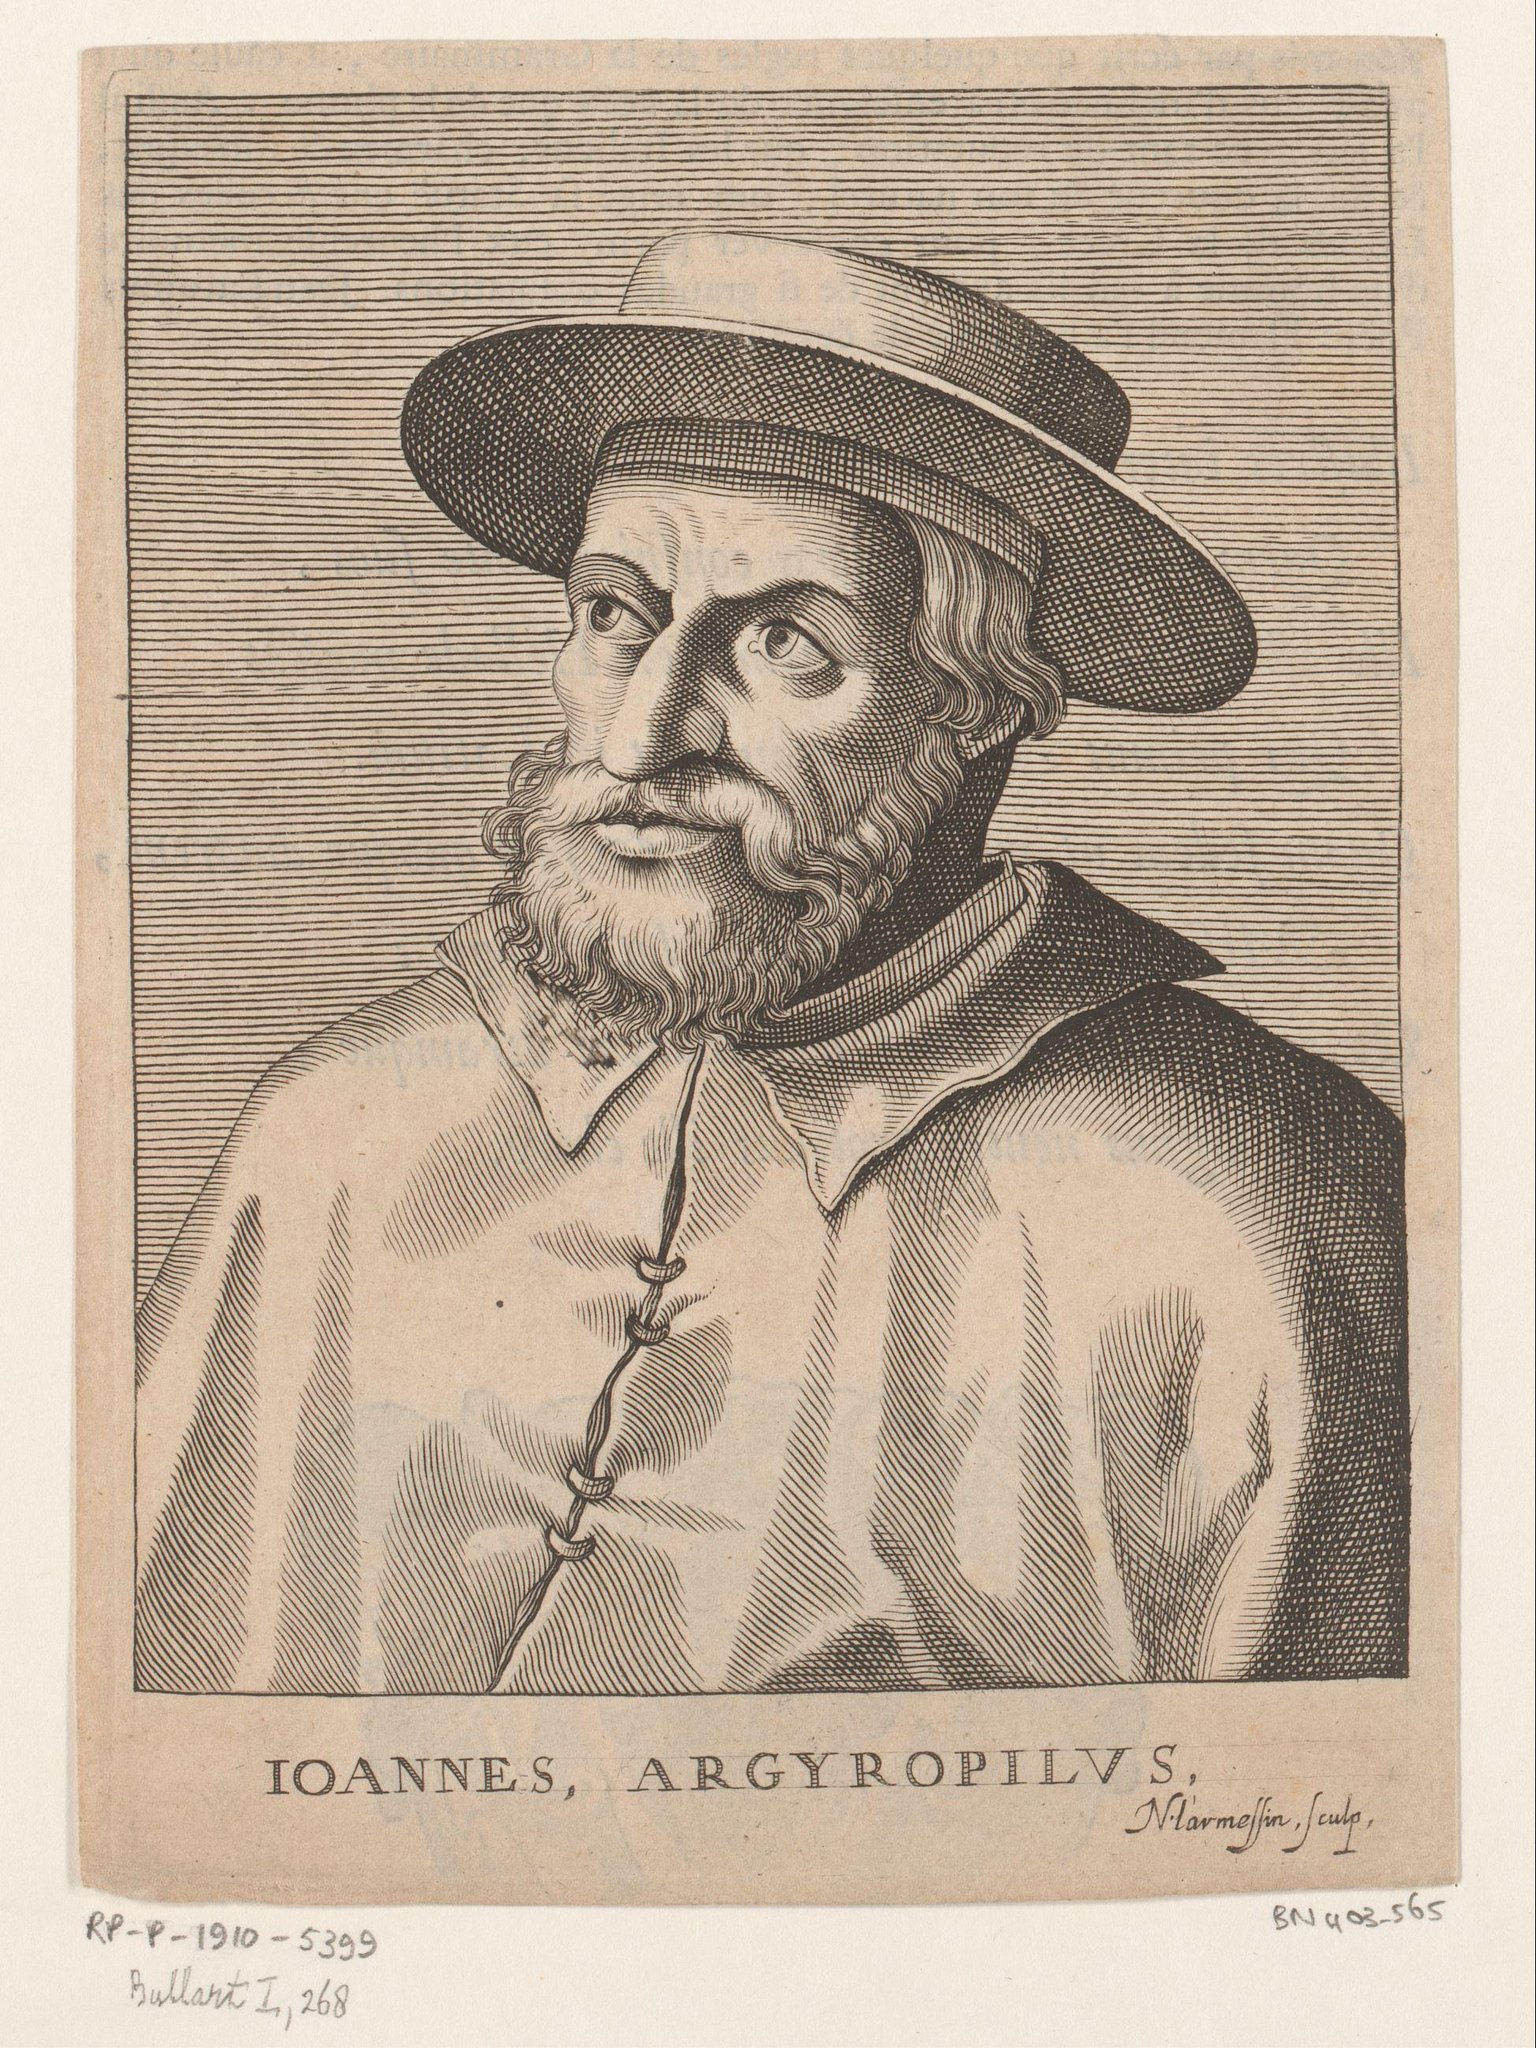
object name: book illustration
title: Portret van Johannes Argyropylus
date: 1682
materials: paper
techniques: engraving, letterpress printing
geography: brussels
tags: rome, scholar, philosopher, historical persons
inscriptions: collector's mark: Lugt 2228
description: Prent gebruikt voor: Bullart, Isaac. Académie des Sciences et Arts contenant les vies et éloges his. des hommes illustres qui ont excellé en ces professions depuis environ quatre siècles. Brussel: François Foppens, 1682. Het boek werd in 1682 eveneens in Amsterdam uitgegeven door de erfgenamen van Daniel Elzevier. Ieder portret betreft een illustratie bij de biografie van een kunstenaar of geleerde. De meeste portretten werden door Nicolas de Larmessin vervaardigd (162), 93 door De Boulonois en een derde door ongeïdentificeerde prentmakers. Dit betreft een illustratie op p. 268, deel I.